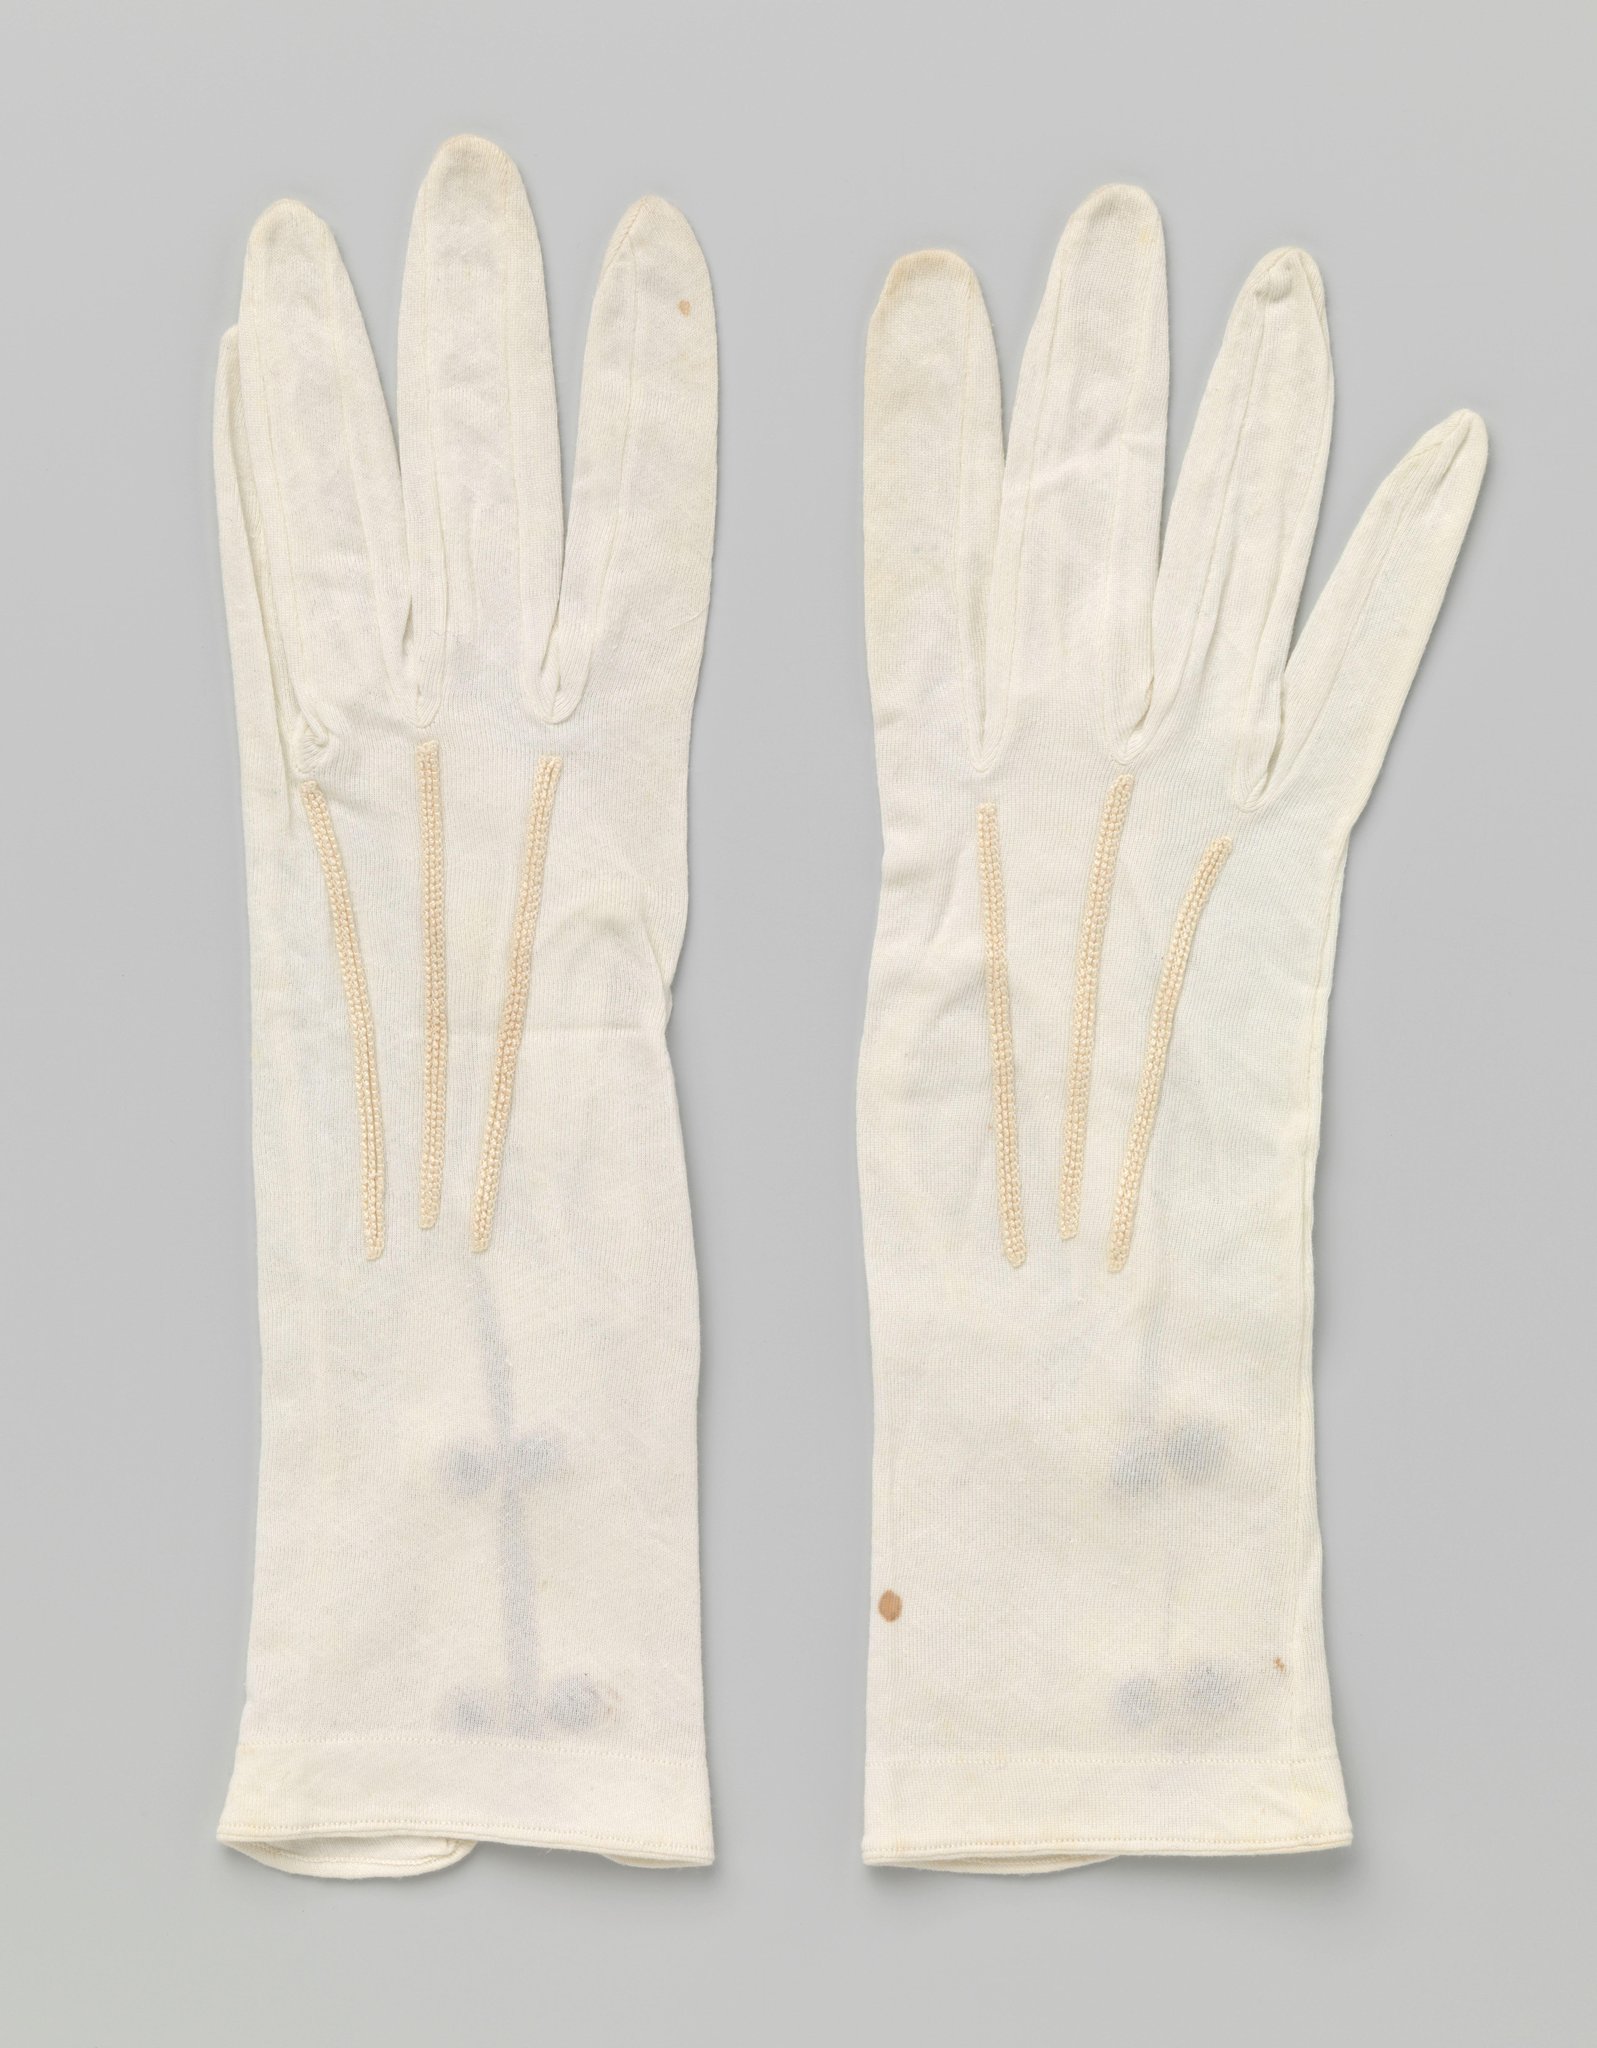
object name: womenswear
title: Handschoen van witte tricot met split en twee drukknopen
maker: Anonymous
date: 1890-1910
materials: cotton, plastic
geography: netherlands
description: Linker handschoen, deel van een paar, van witte katoenen tricot met split en twee drukknopen.